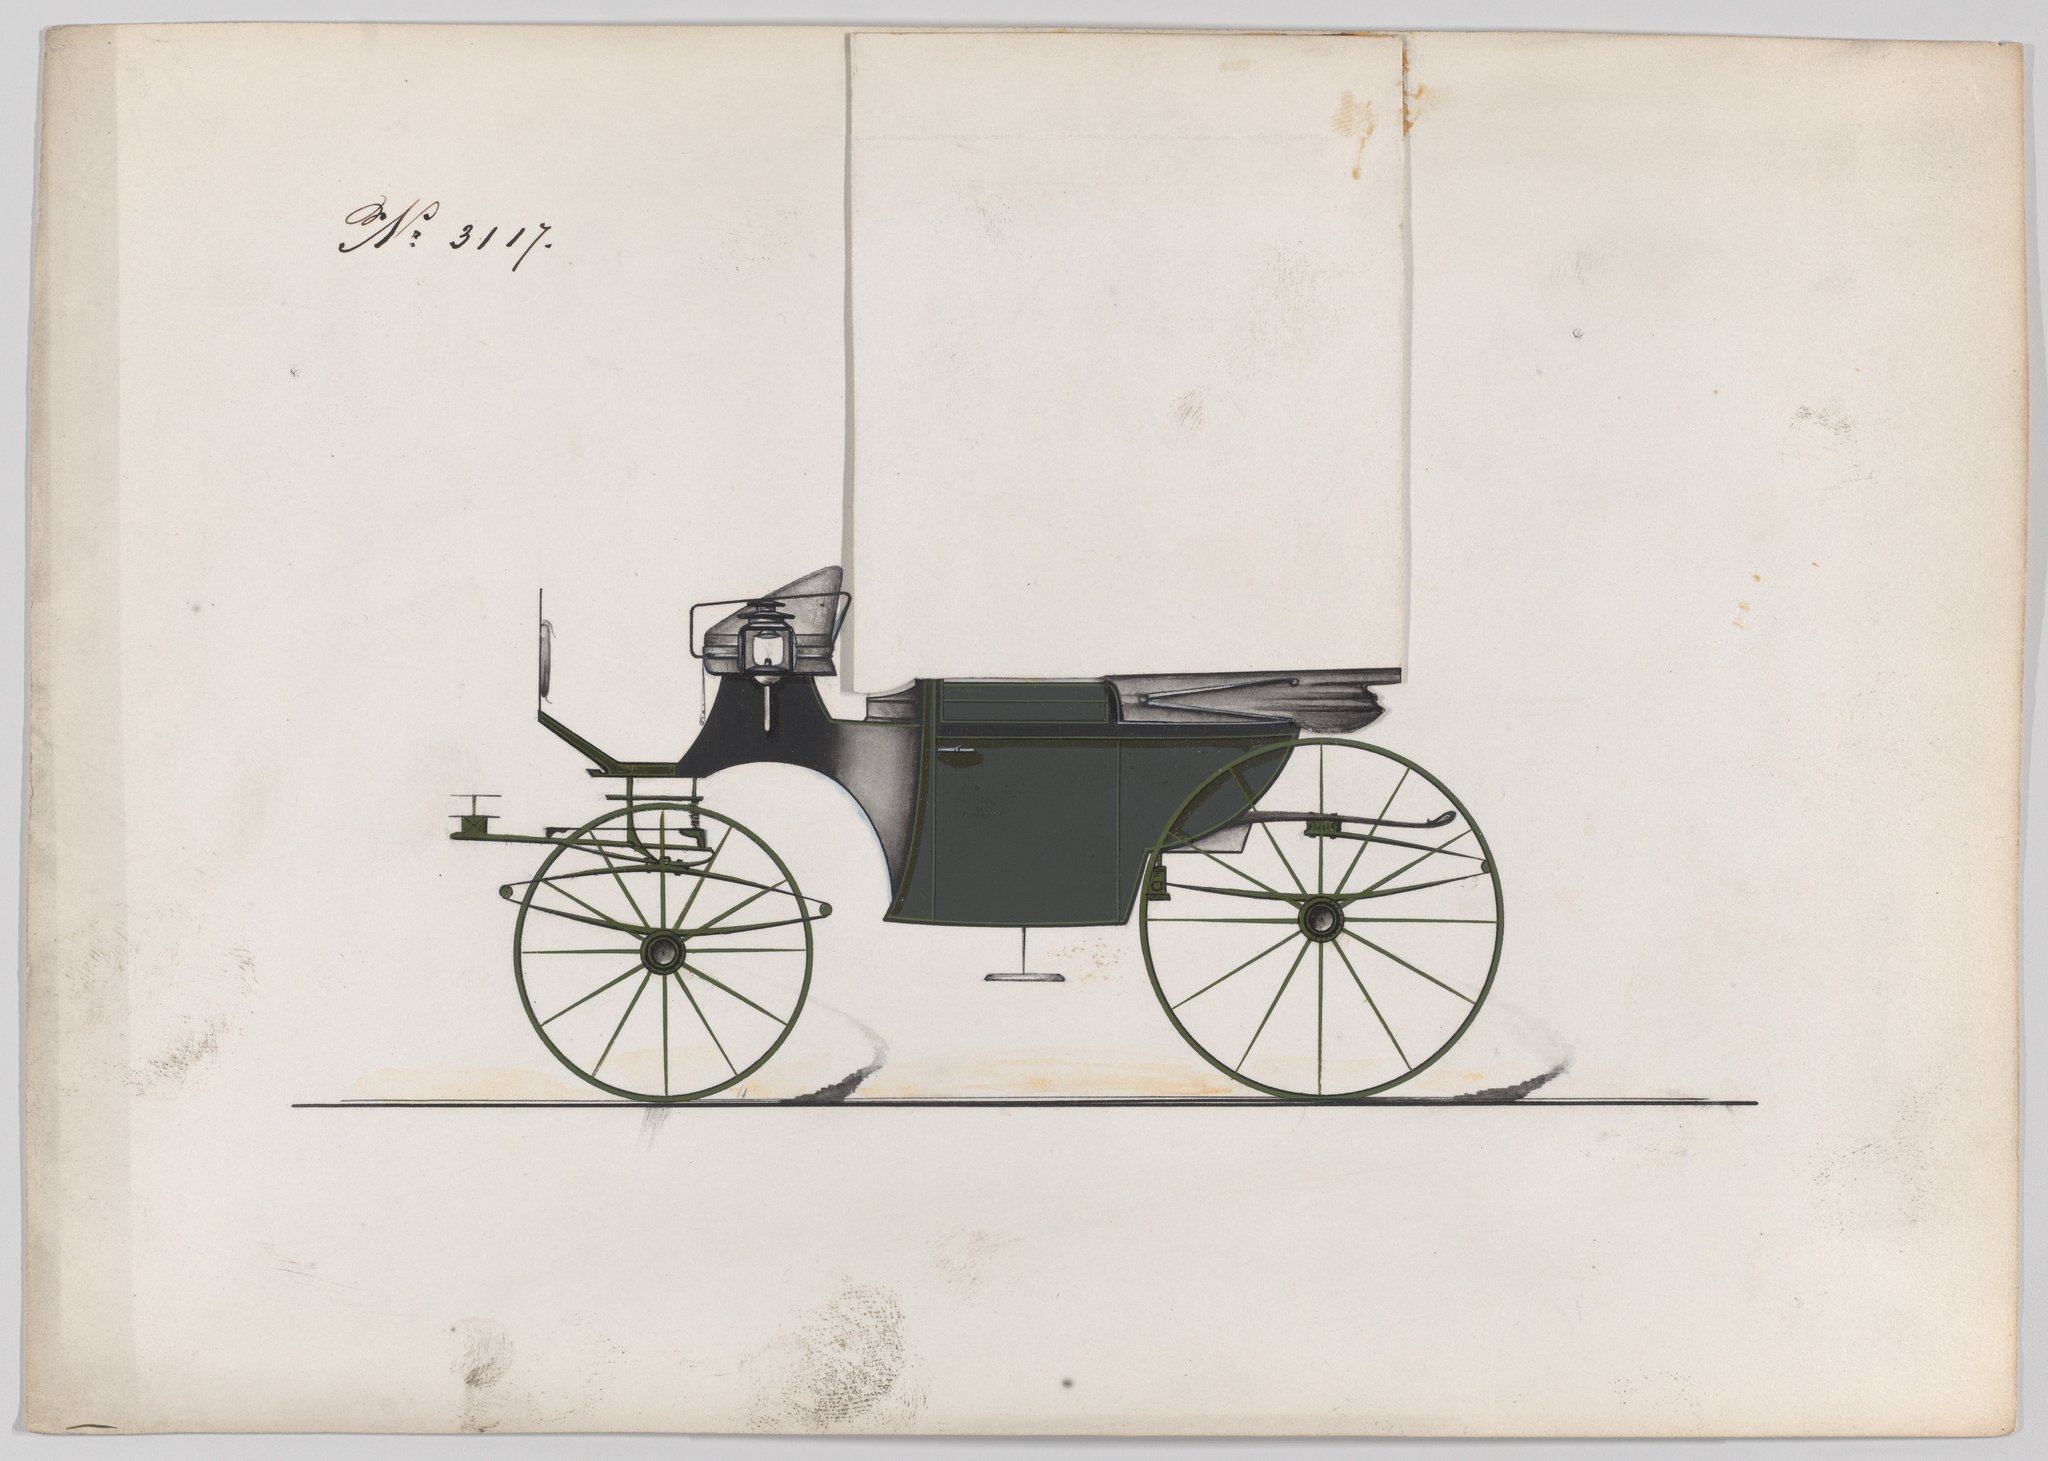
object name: drawing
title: Design for Landaulet, no. 3117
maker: brewster & co.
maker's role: manufacturer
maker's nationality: american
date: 1875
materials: gouache, gum arabic, ink, watercolor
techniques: pen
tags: carriages